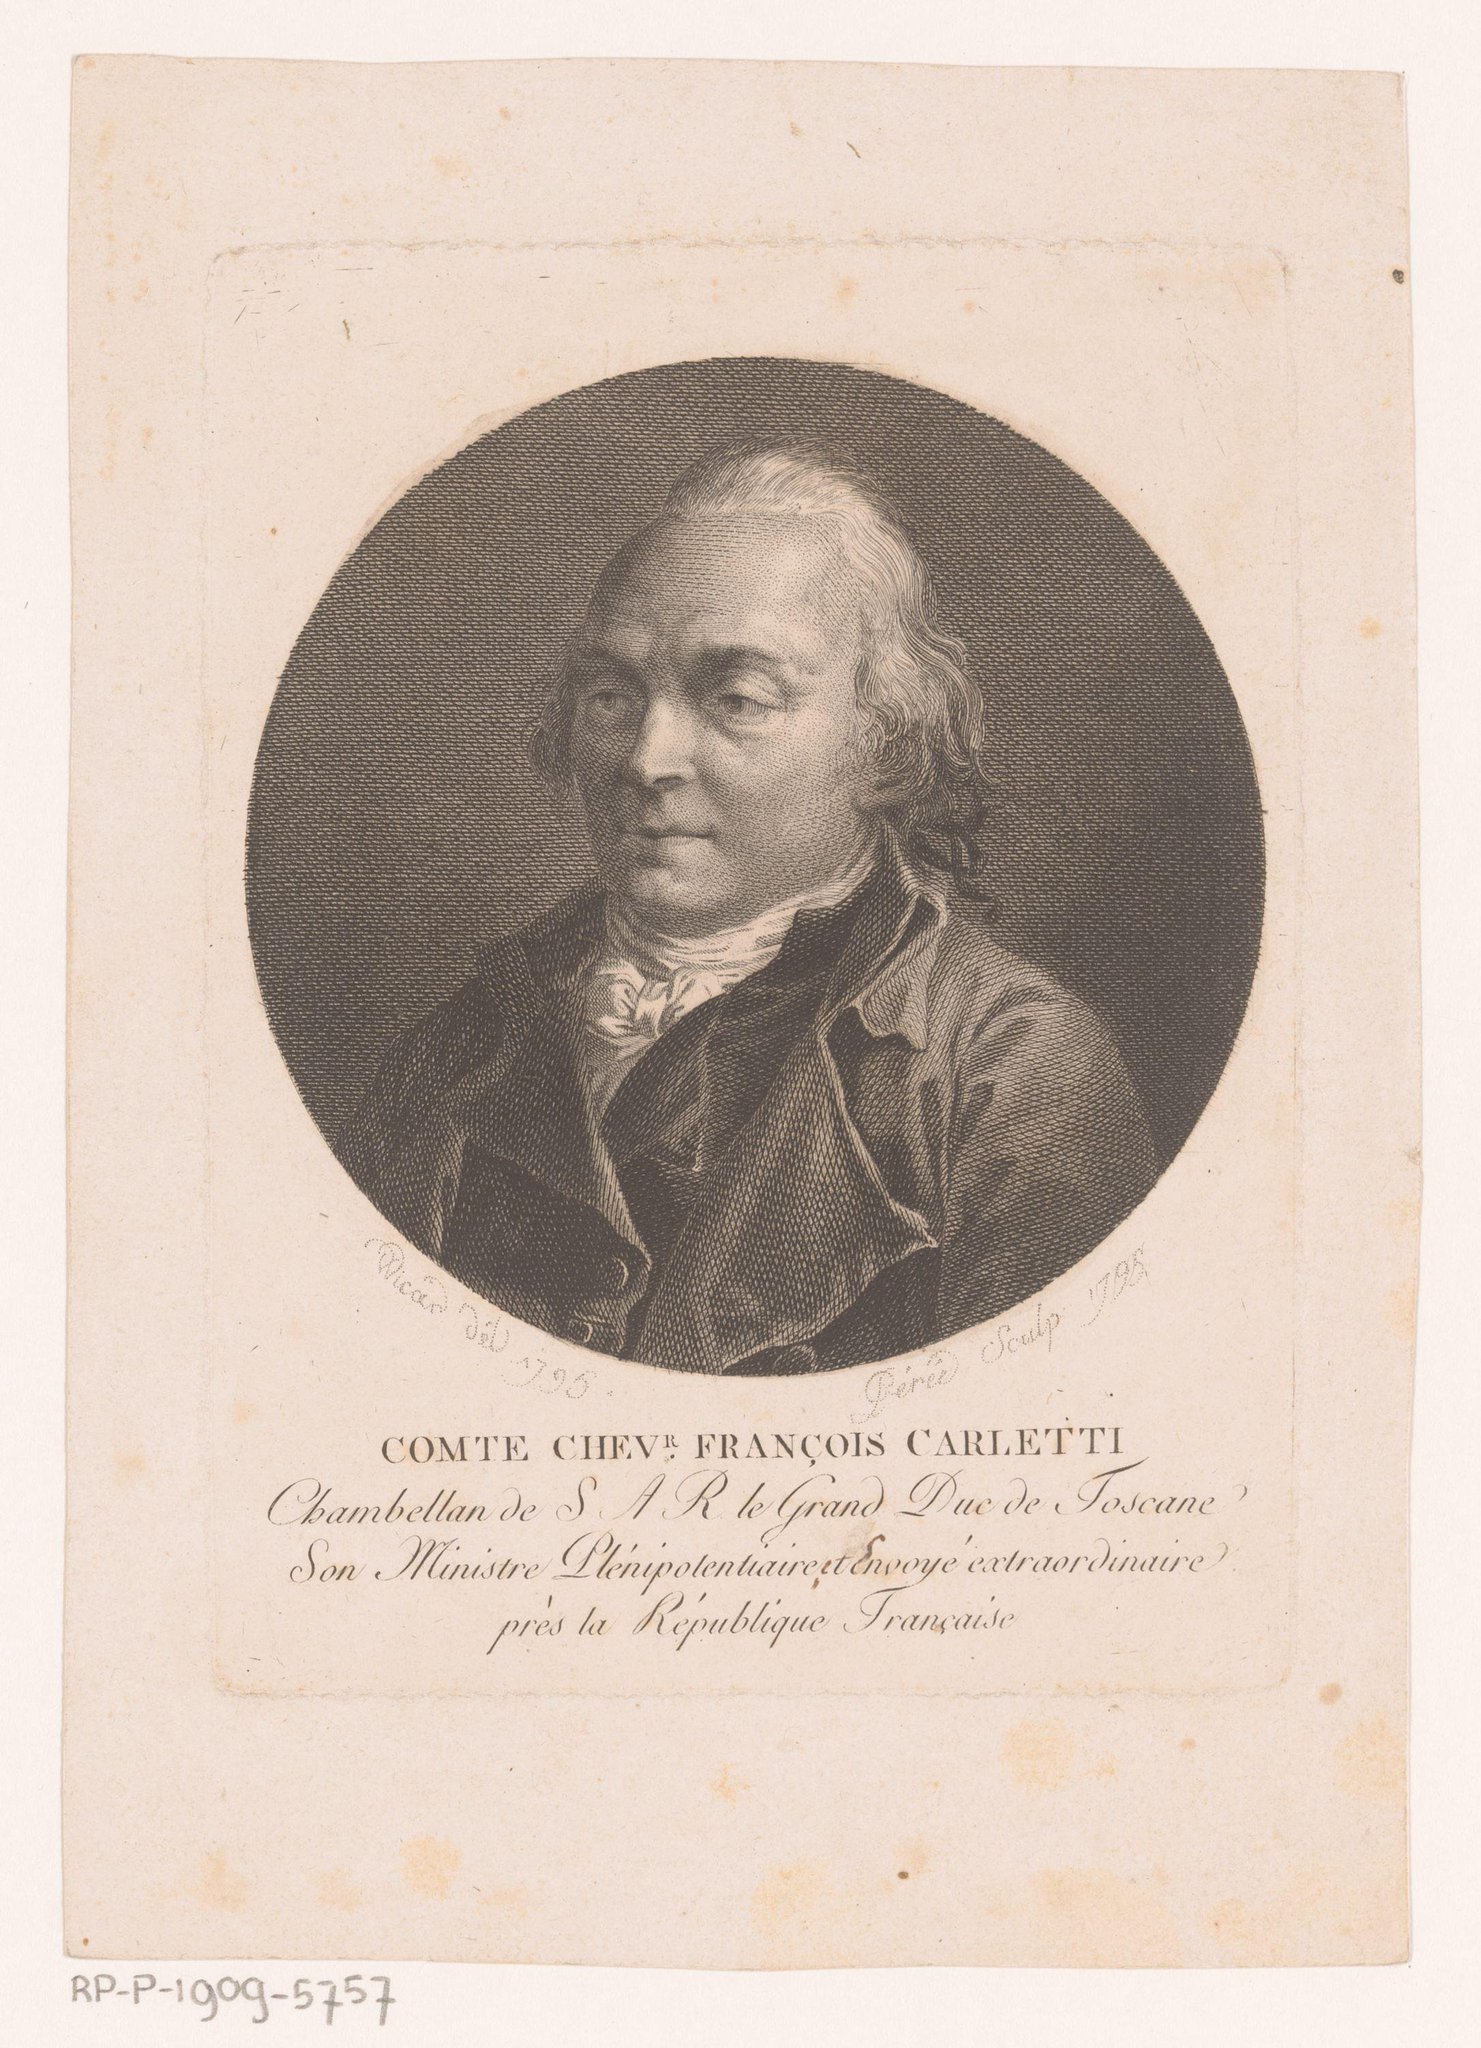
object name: print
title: Comte Chevr François Carletti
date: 1795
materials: paper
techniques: engraving, etching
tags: earl, official; civil servant; functionary (in general), historical persons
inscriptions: collector's mark: Lugt 2228